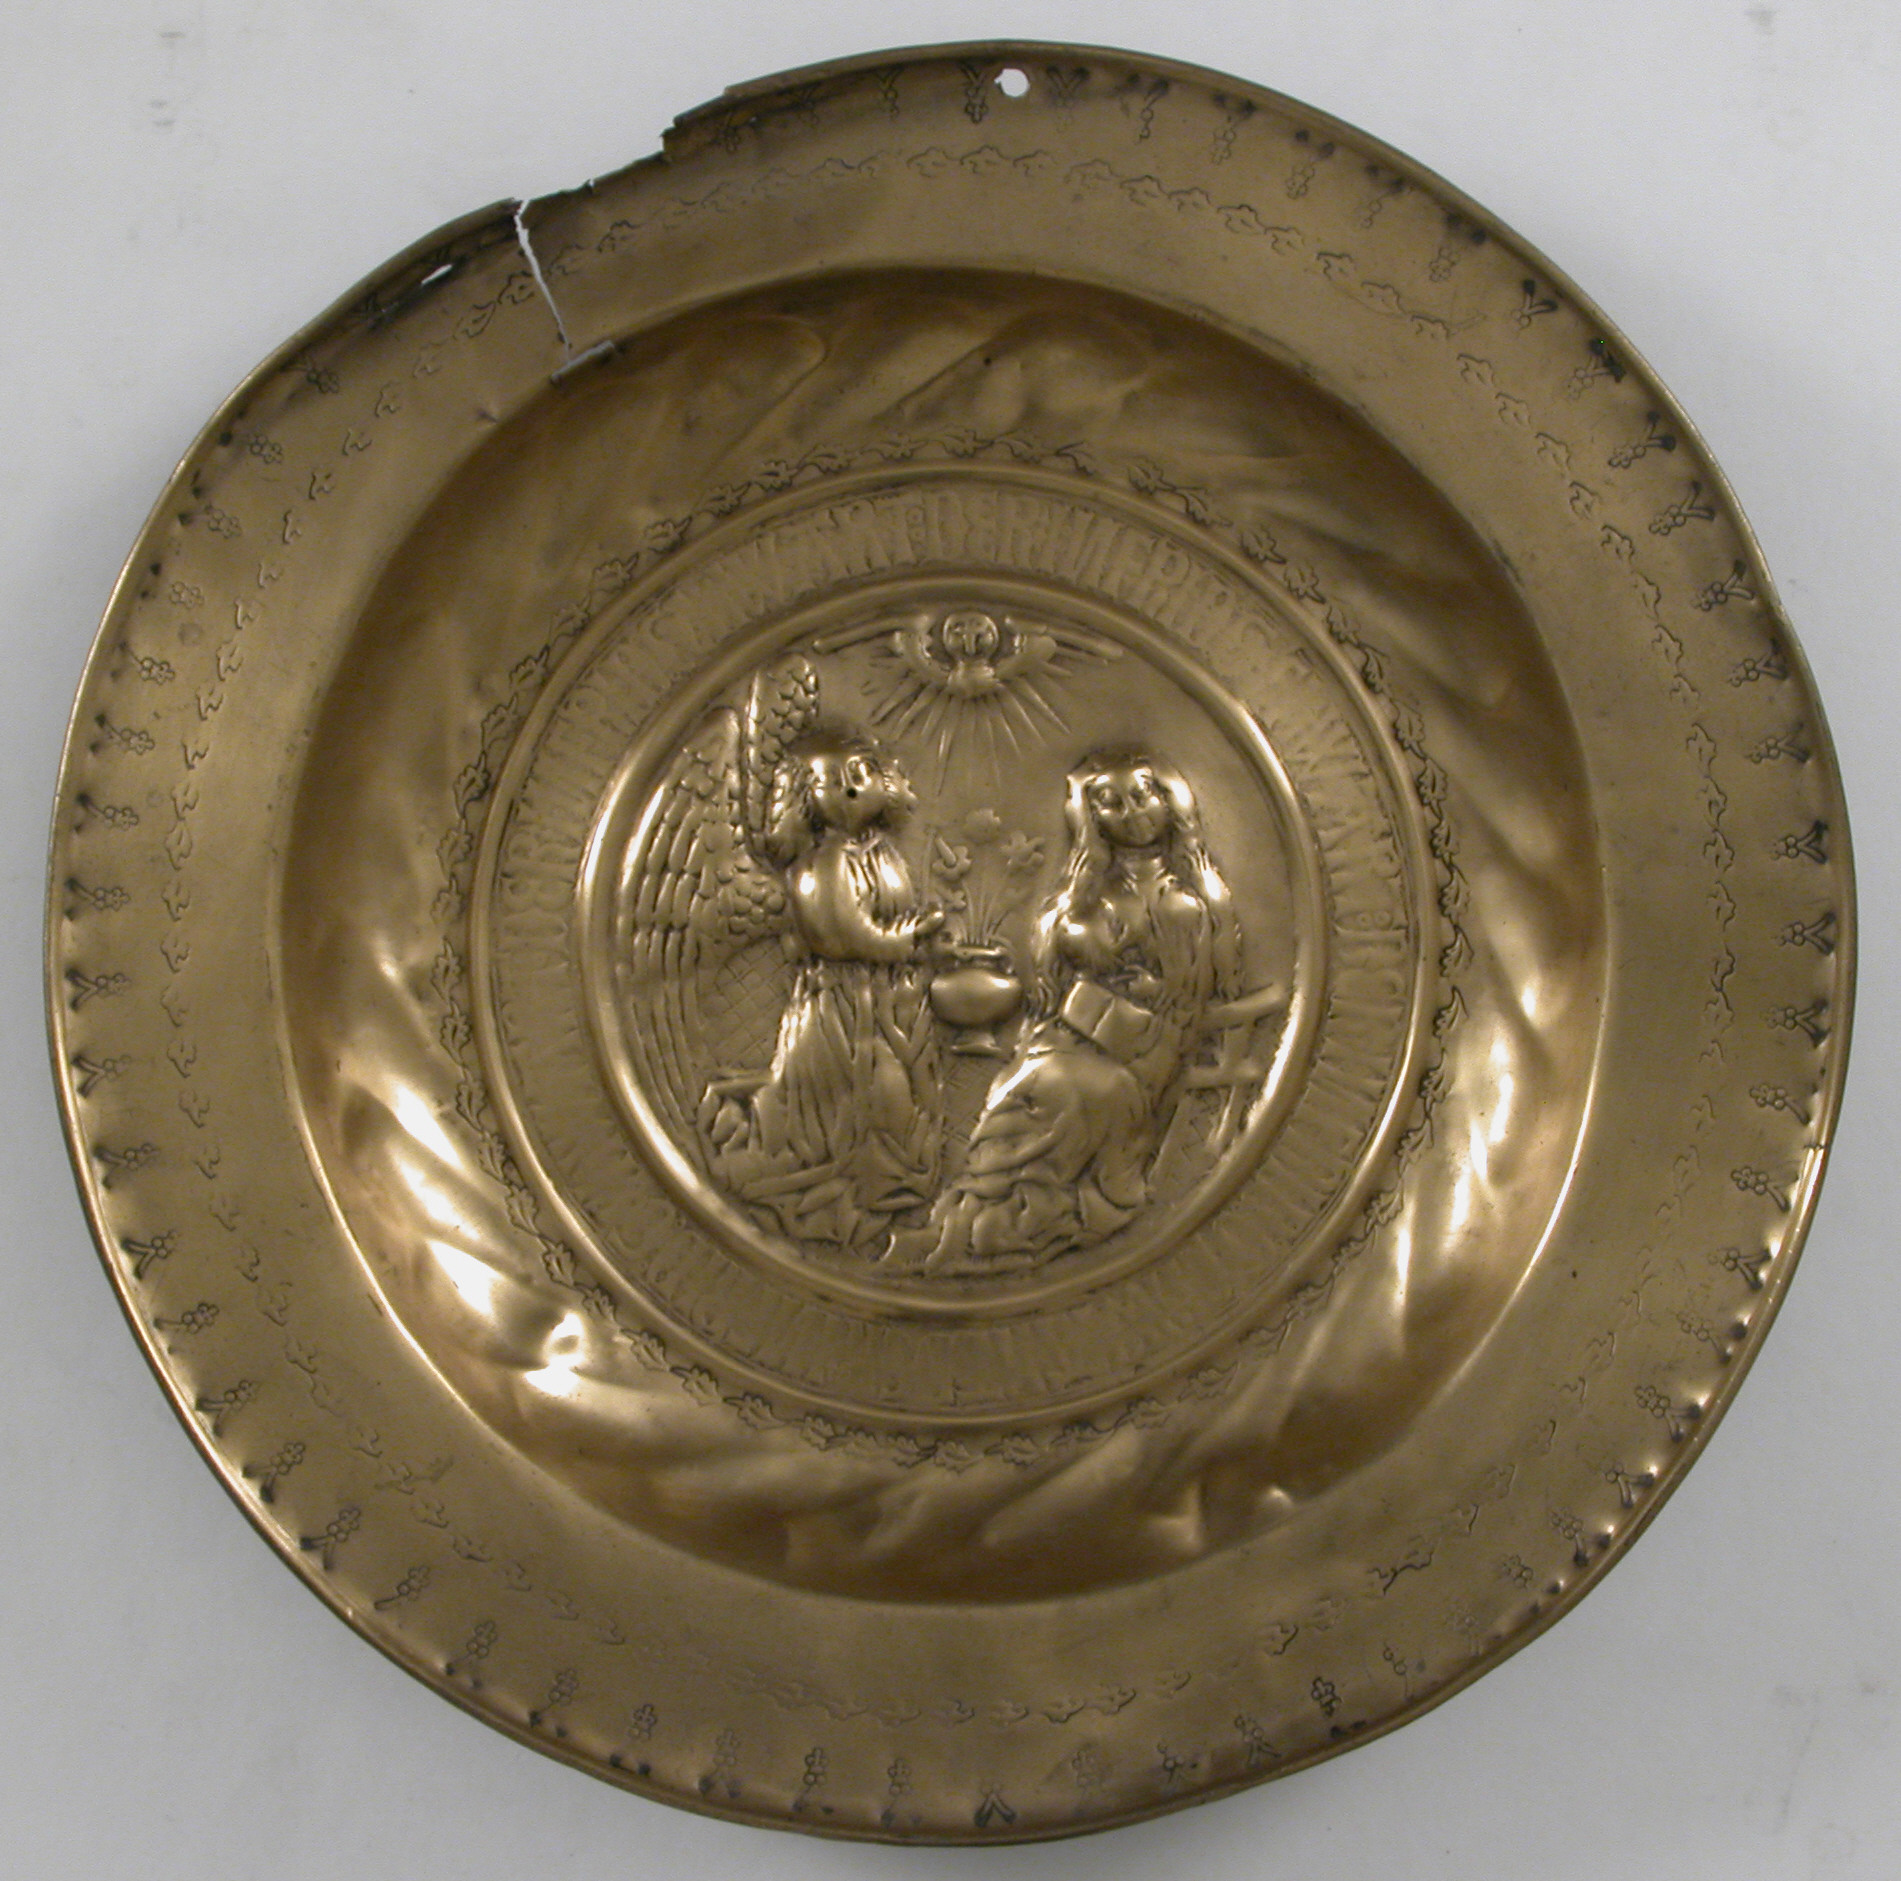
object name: dish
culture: german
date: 1501-1533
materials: brass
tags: women